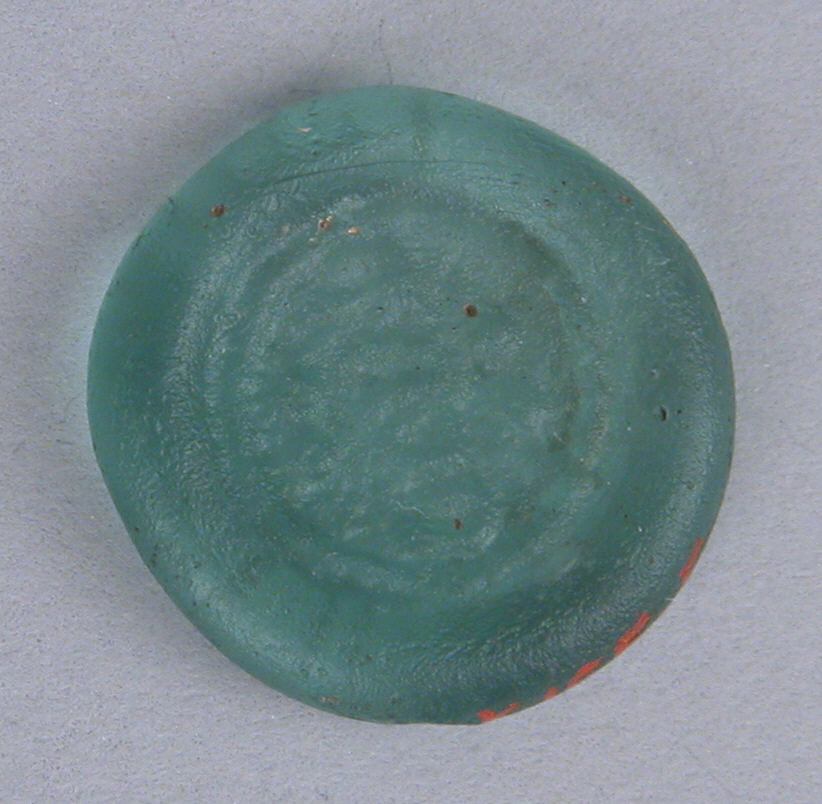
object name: coin weight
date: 1001-1100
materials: glass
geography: egypt